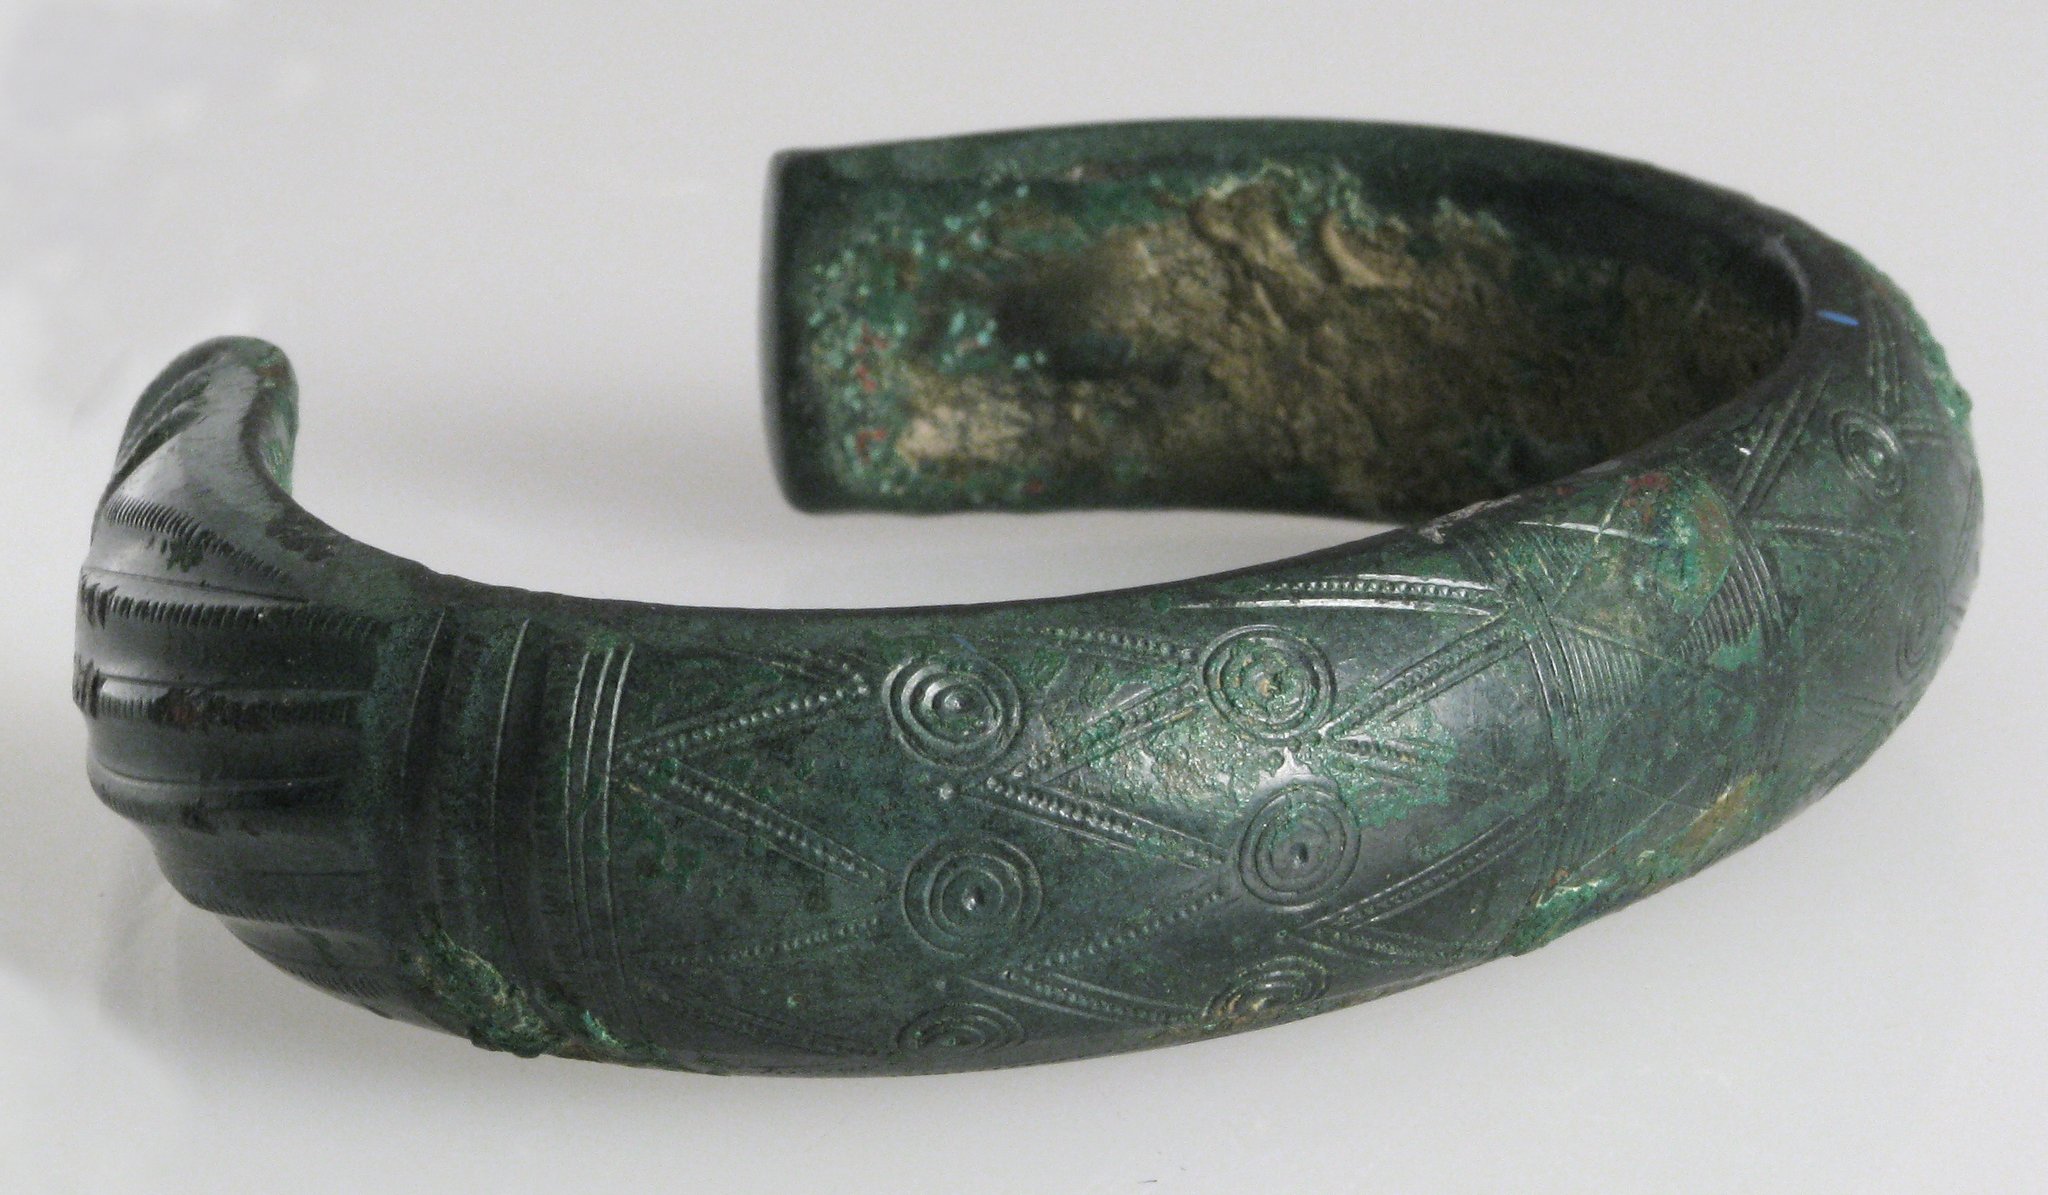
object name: bracelet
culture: hallstatt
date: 1200-800 BCE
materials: copper alloy